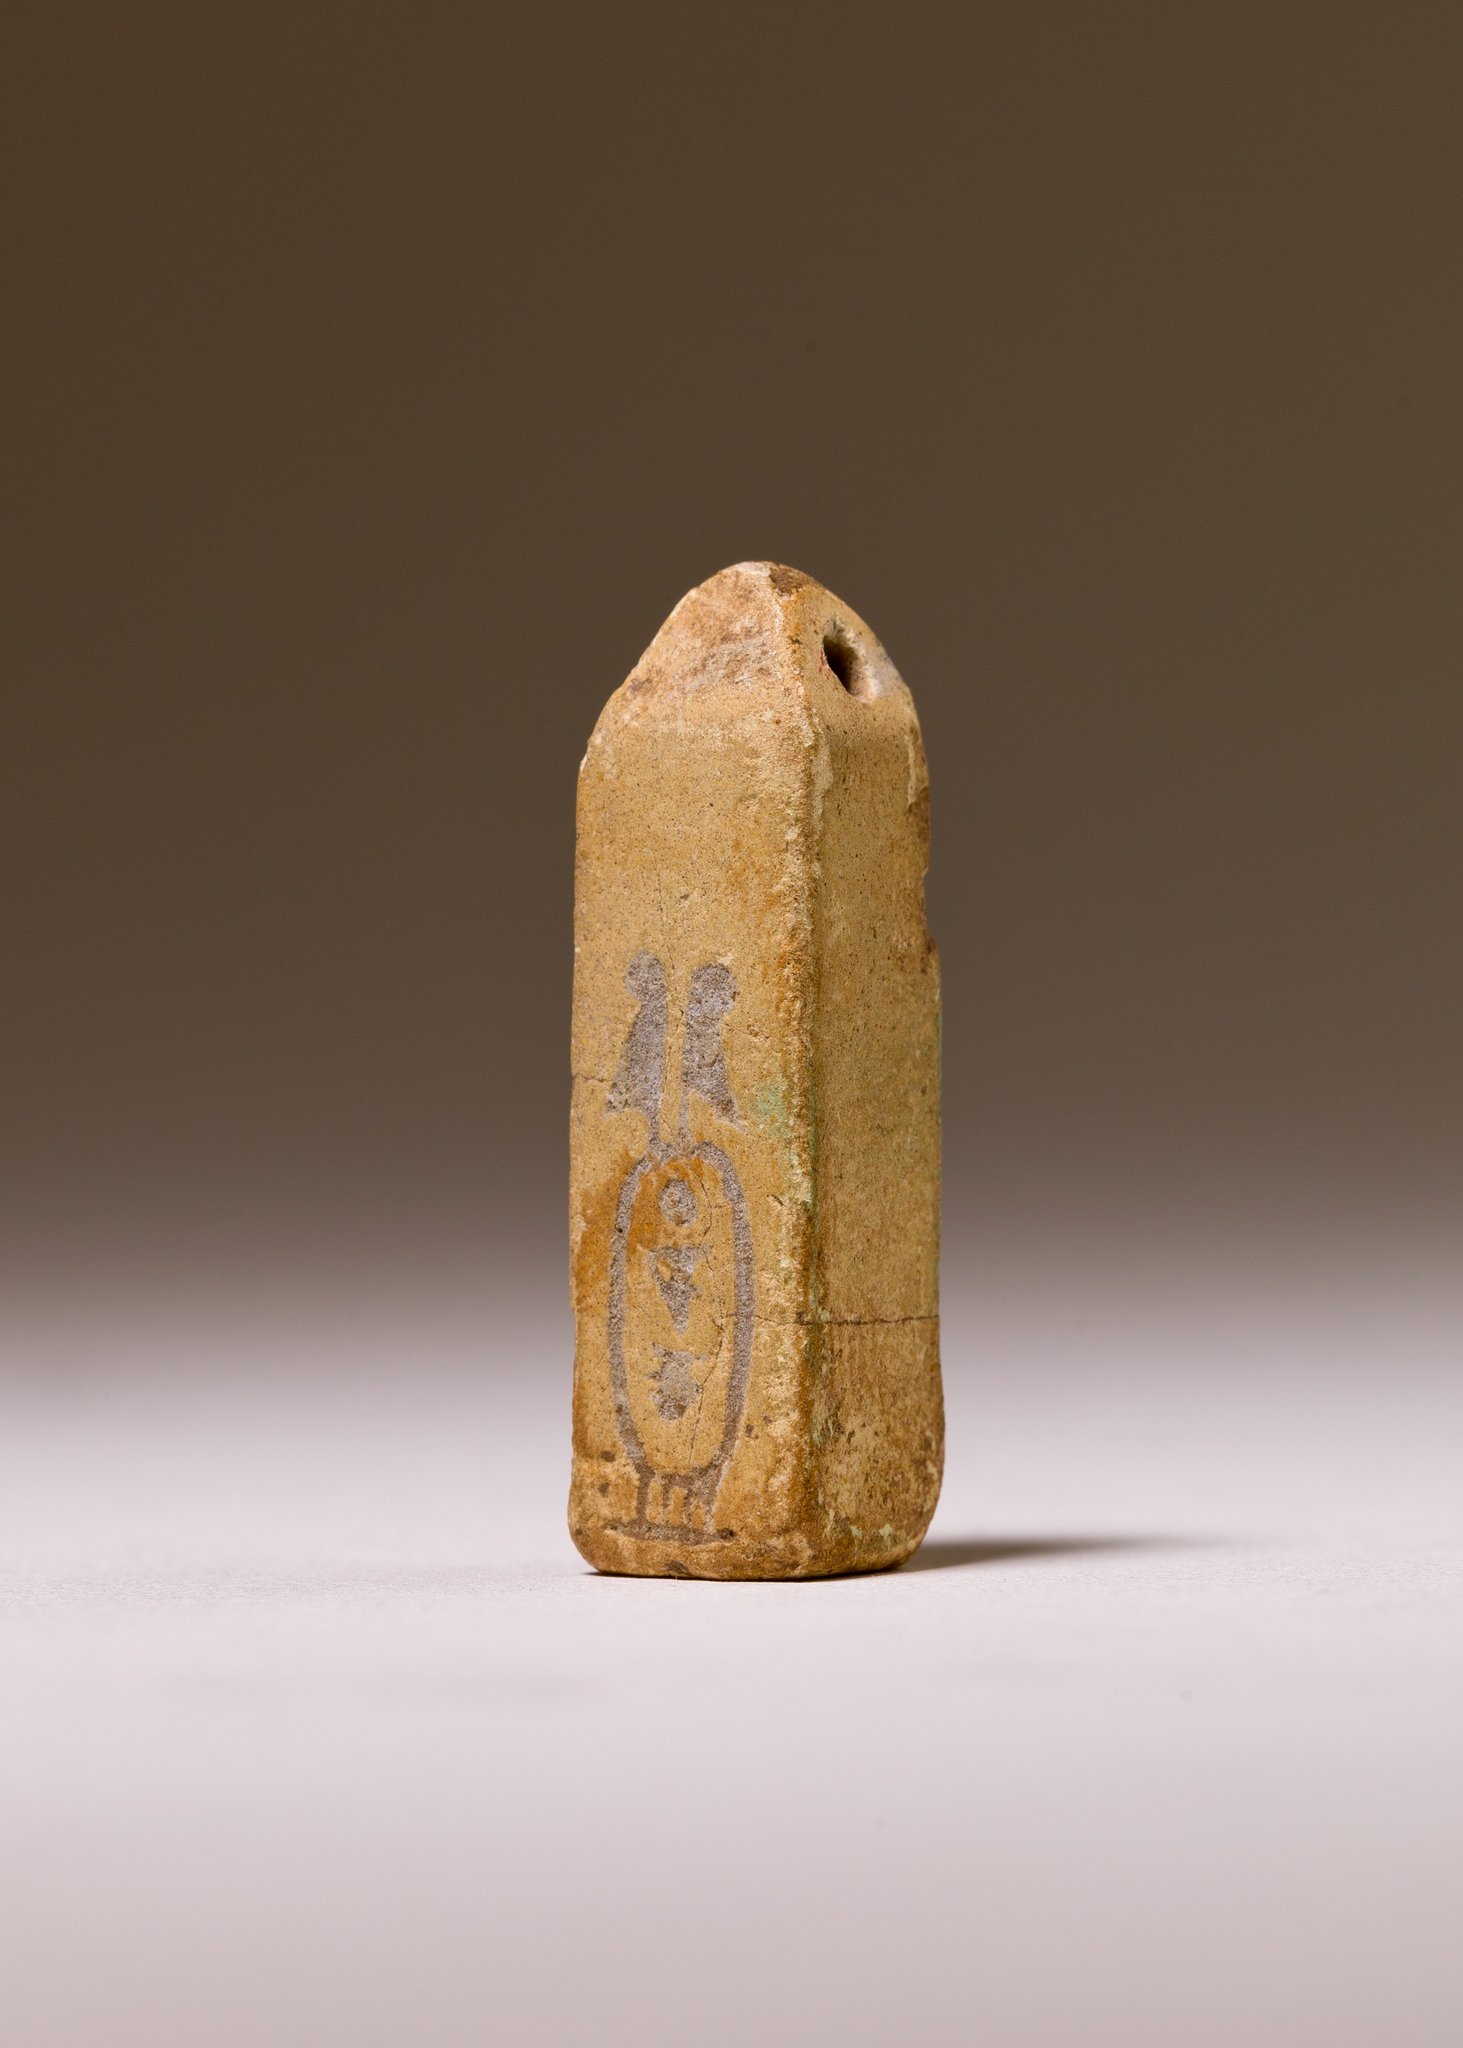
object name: seal, amasis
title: Seal or amulet inscribed with the name of Amasis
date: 570-526 BCE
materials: faience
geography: egypt